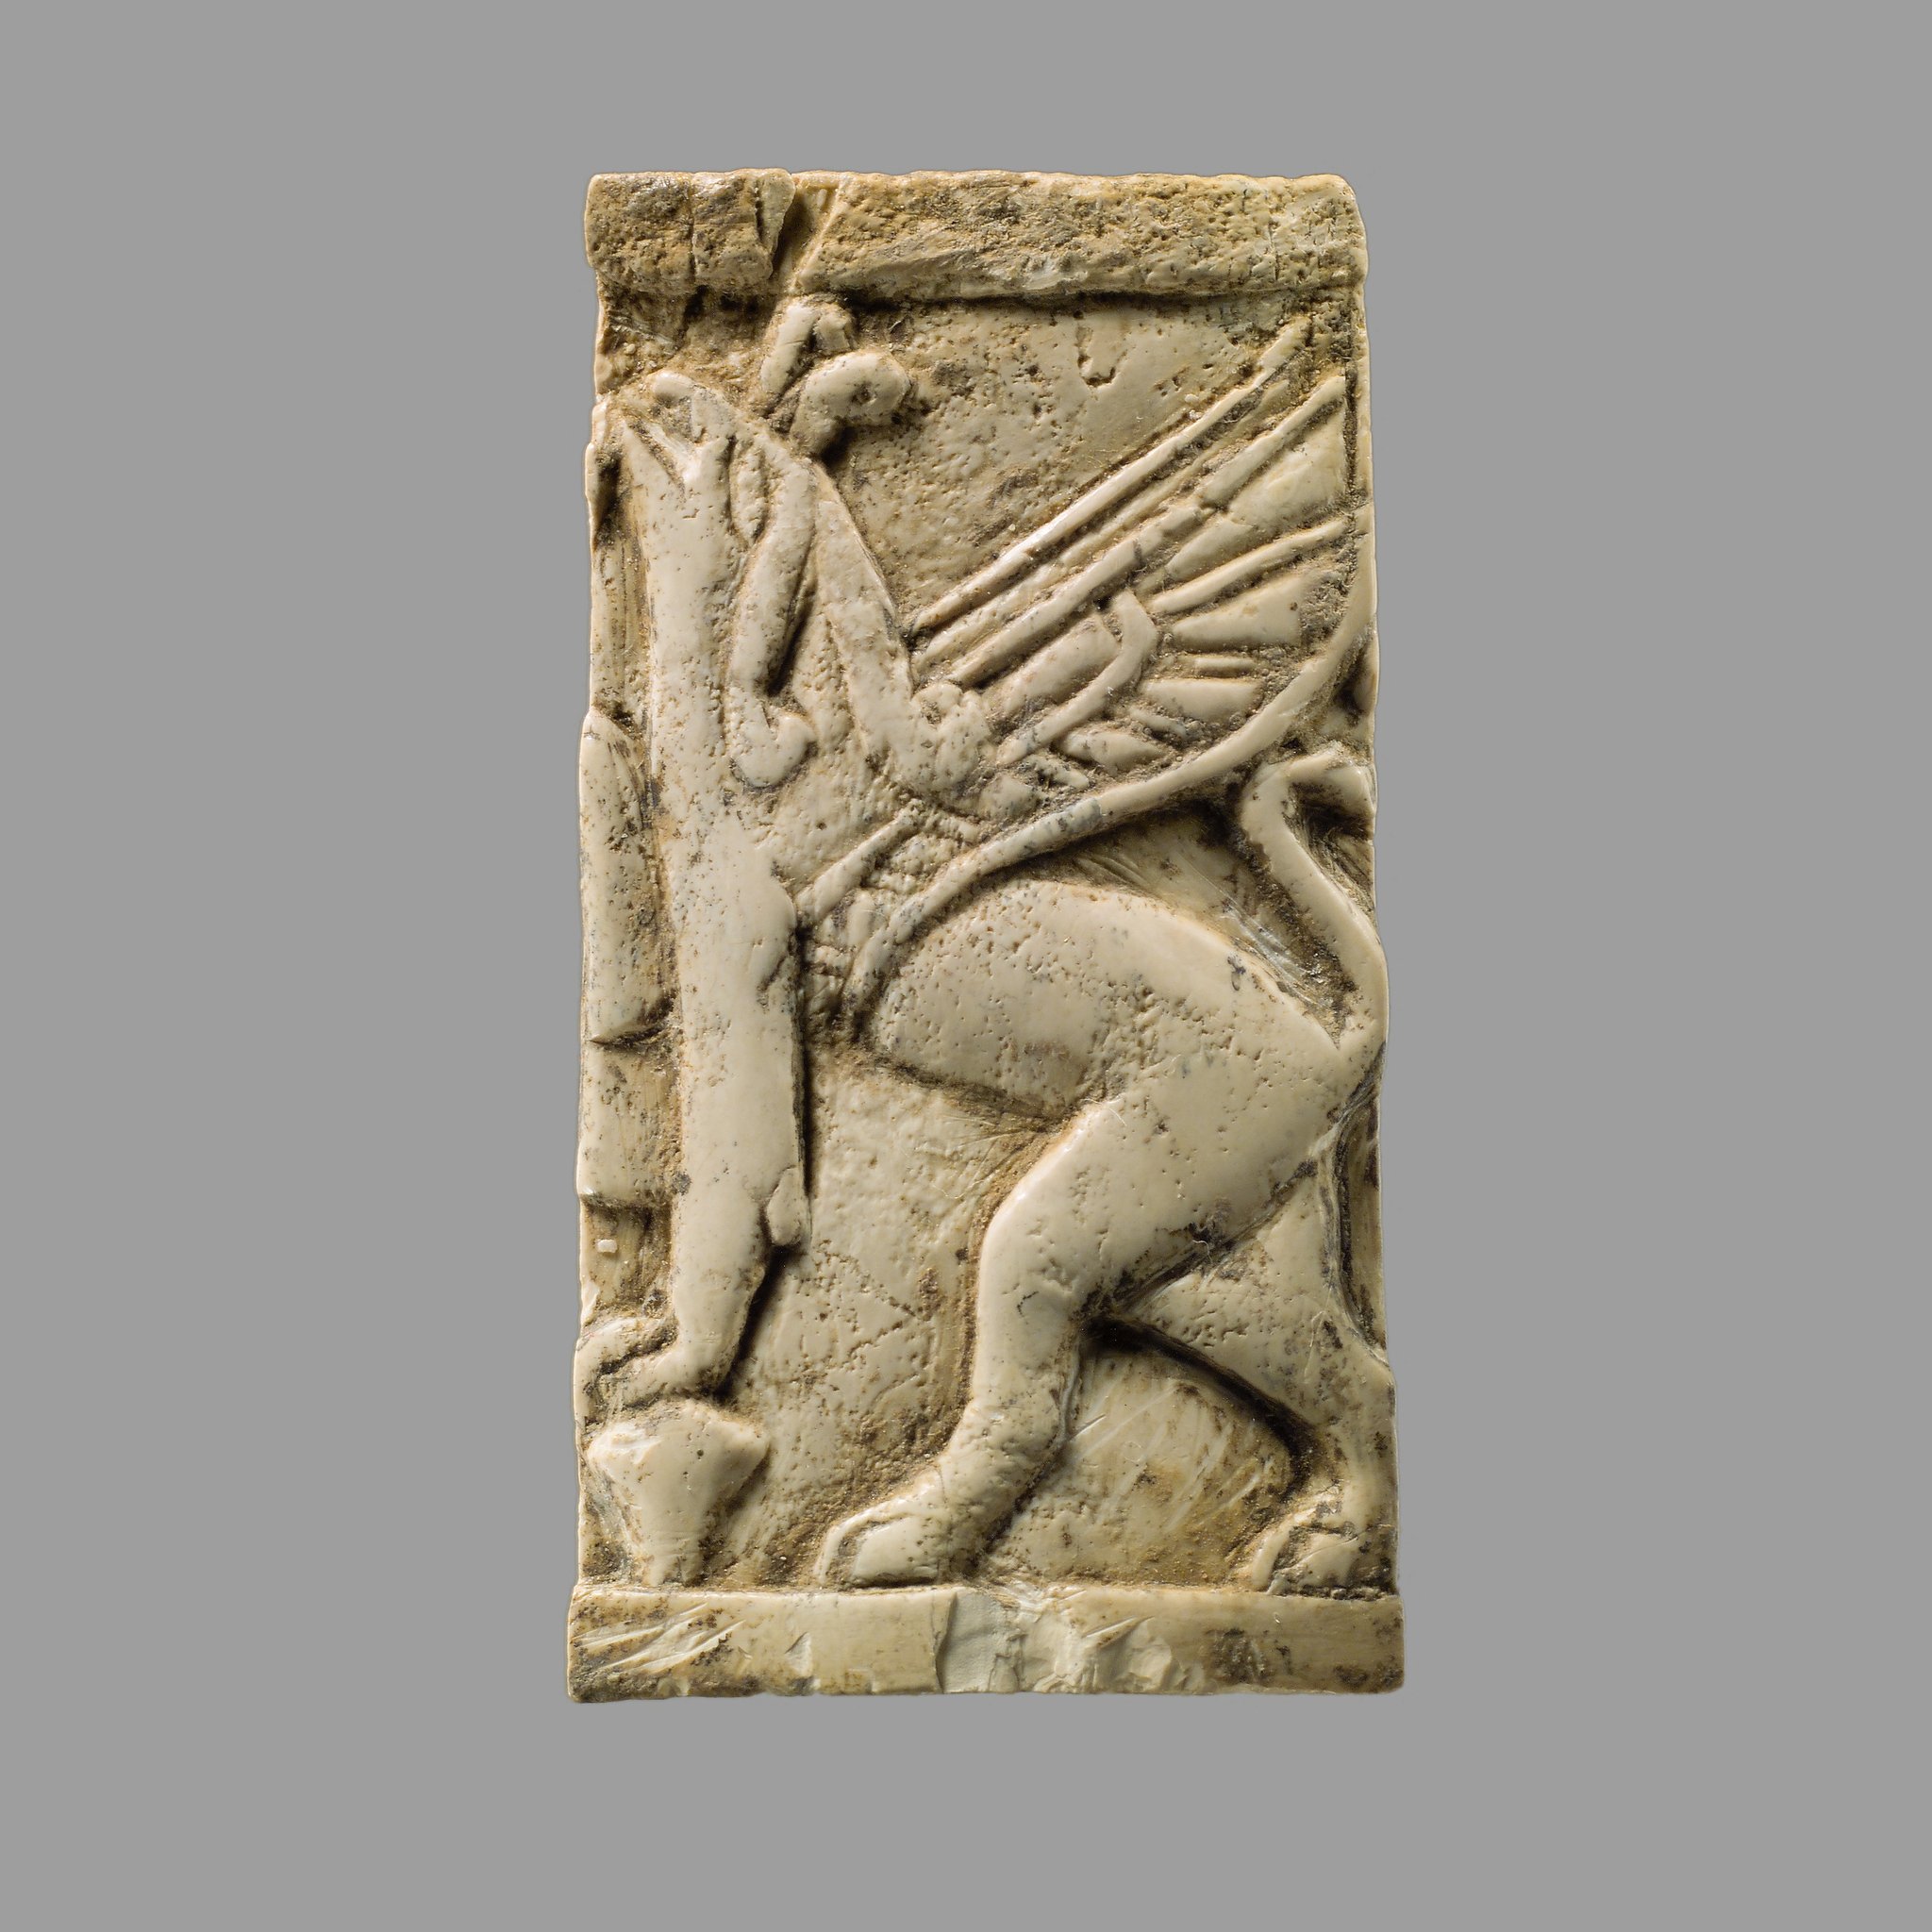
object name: relief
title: Plaque with griffin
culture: assyrian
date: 800-601 BCE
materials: ivory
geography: mesopotamia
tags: griffins